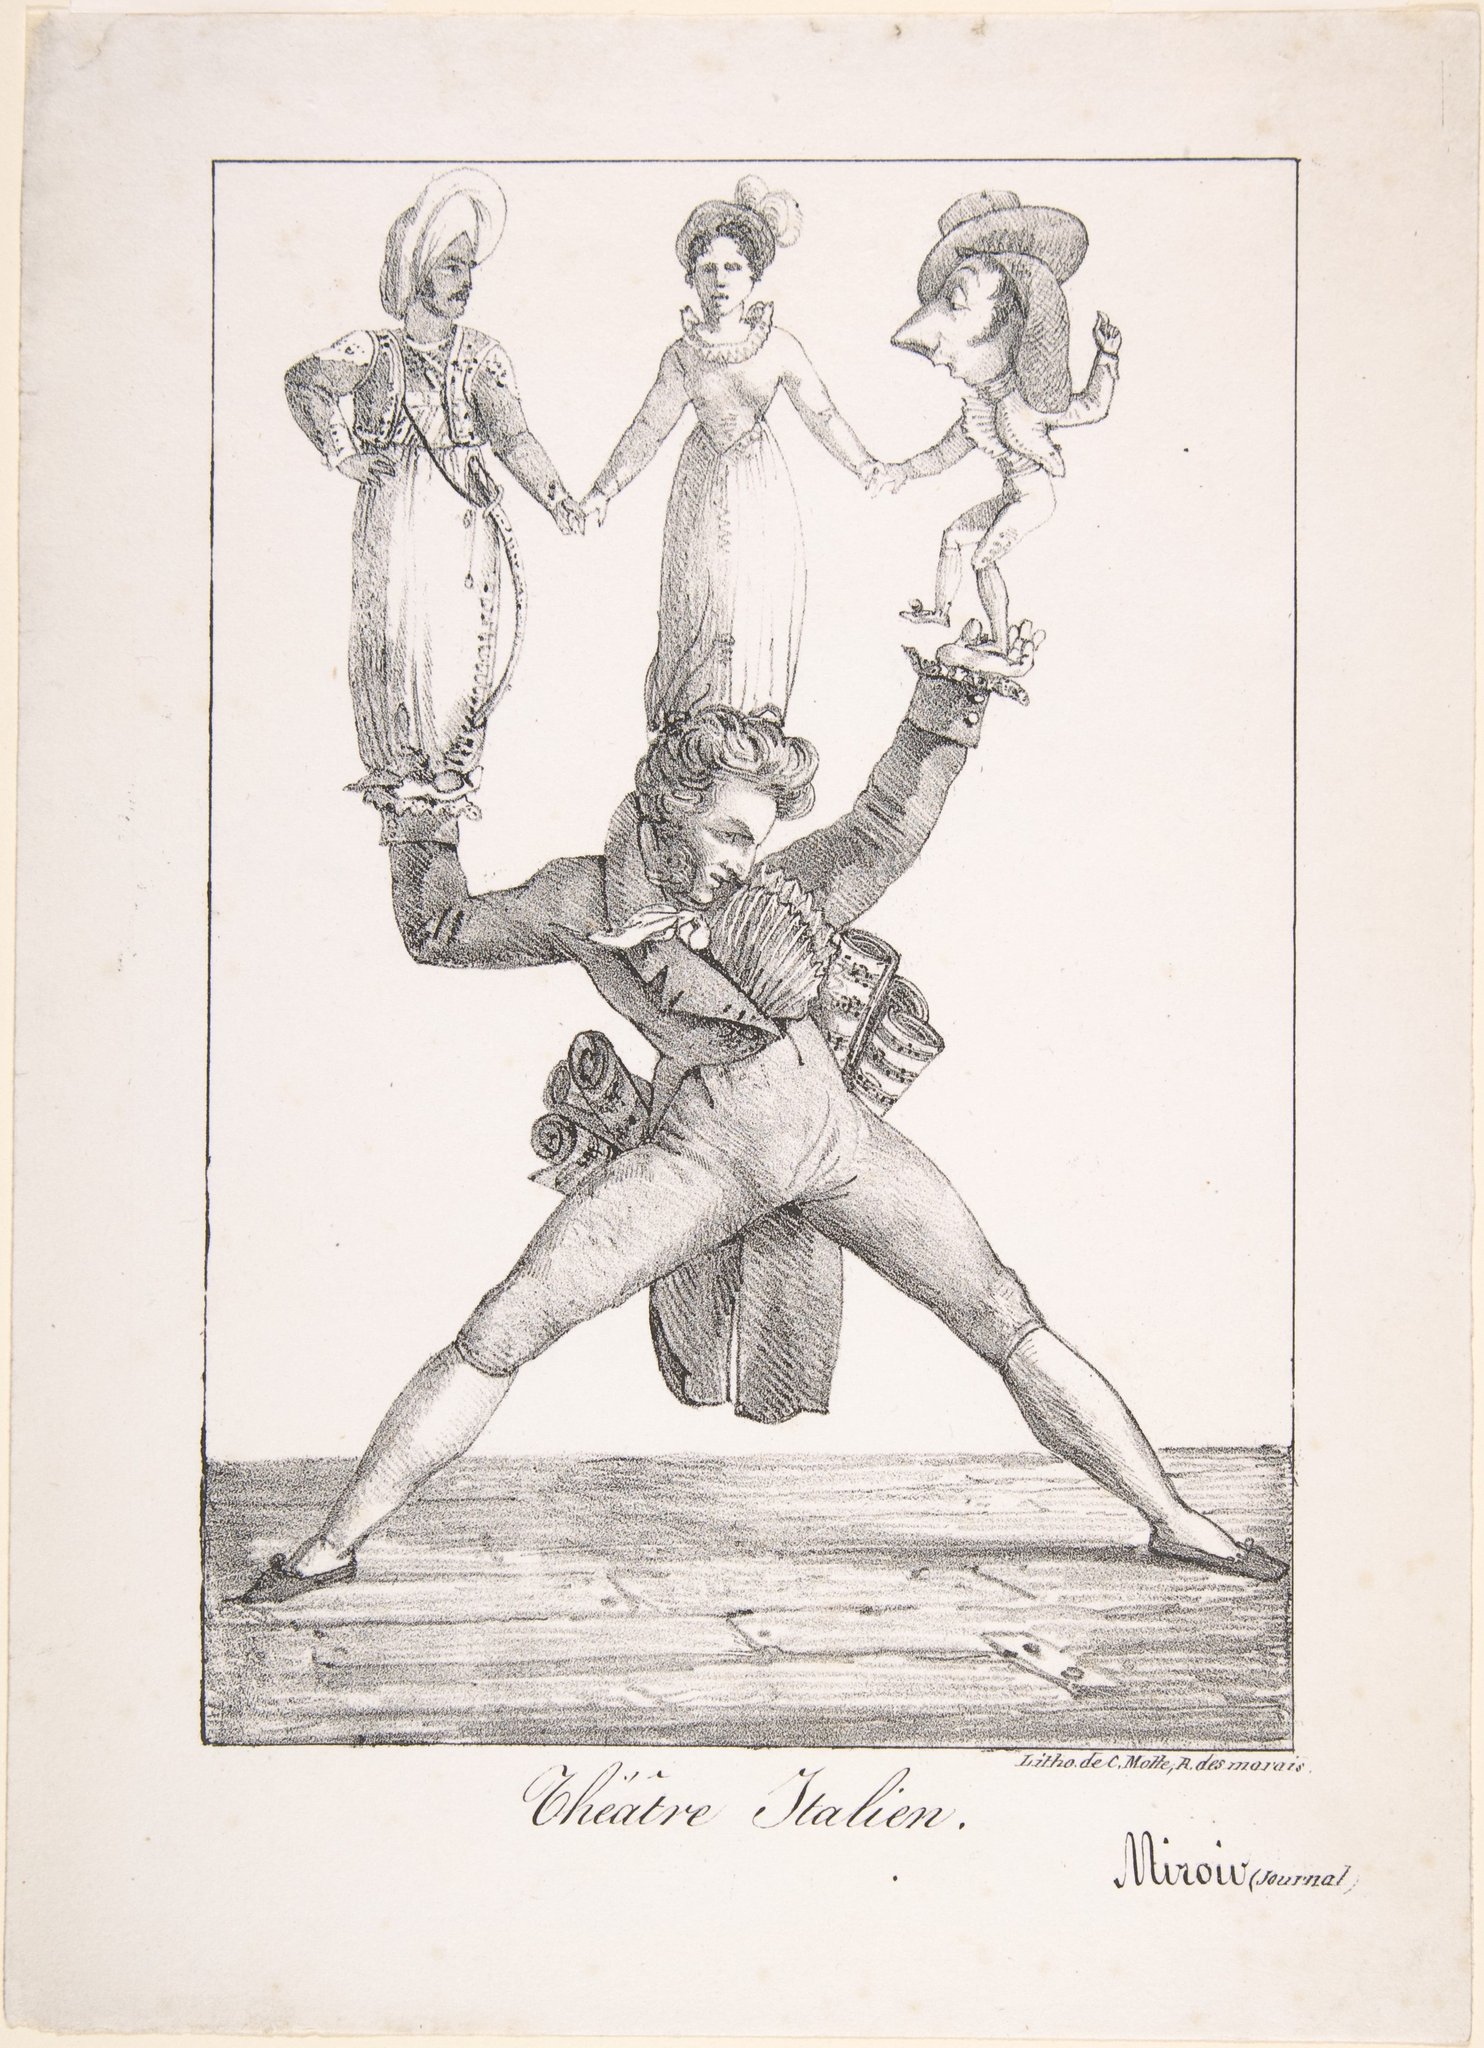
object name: print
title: Théâtre Italien, from "Le Miroir"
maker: eugène delacroix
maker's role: artist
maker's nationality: french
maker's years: 1798-1863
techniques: lithograph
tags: satire,men,women